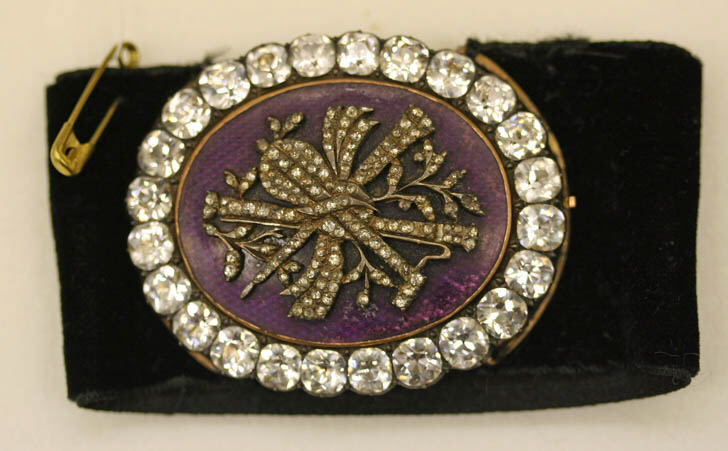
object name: bracelet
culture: french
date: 1834-1866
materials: glass, silver